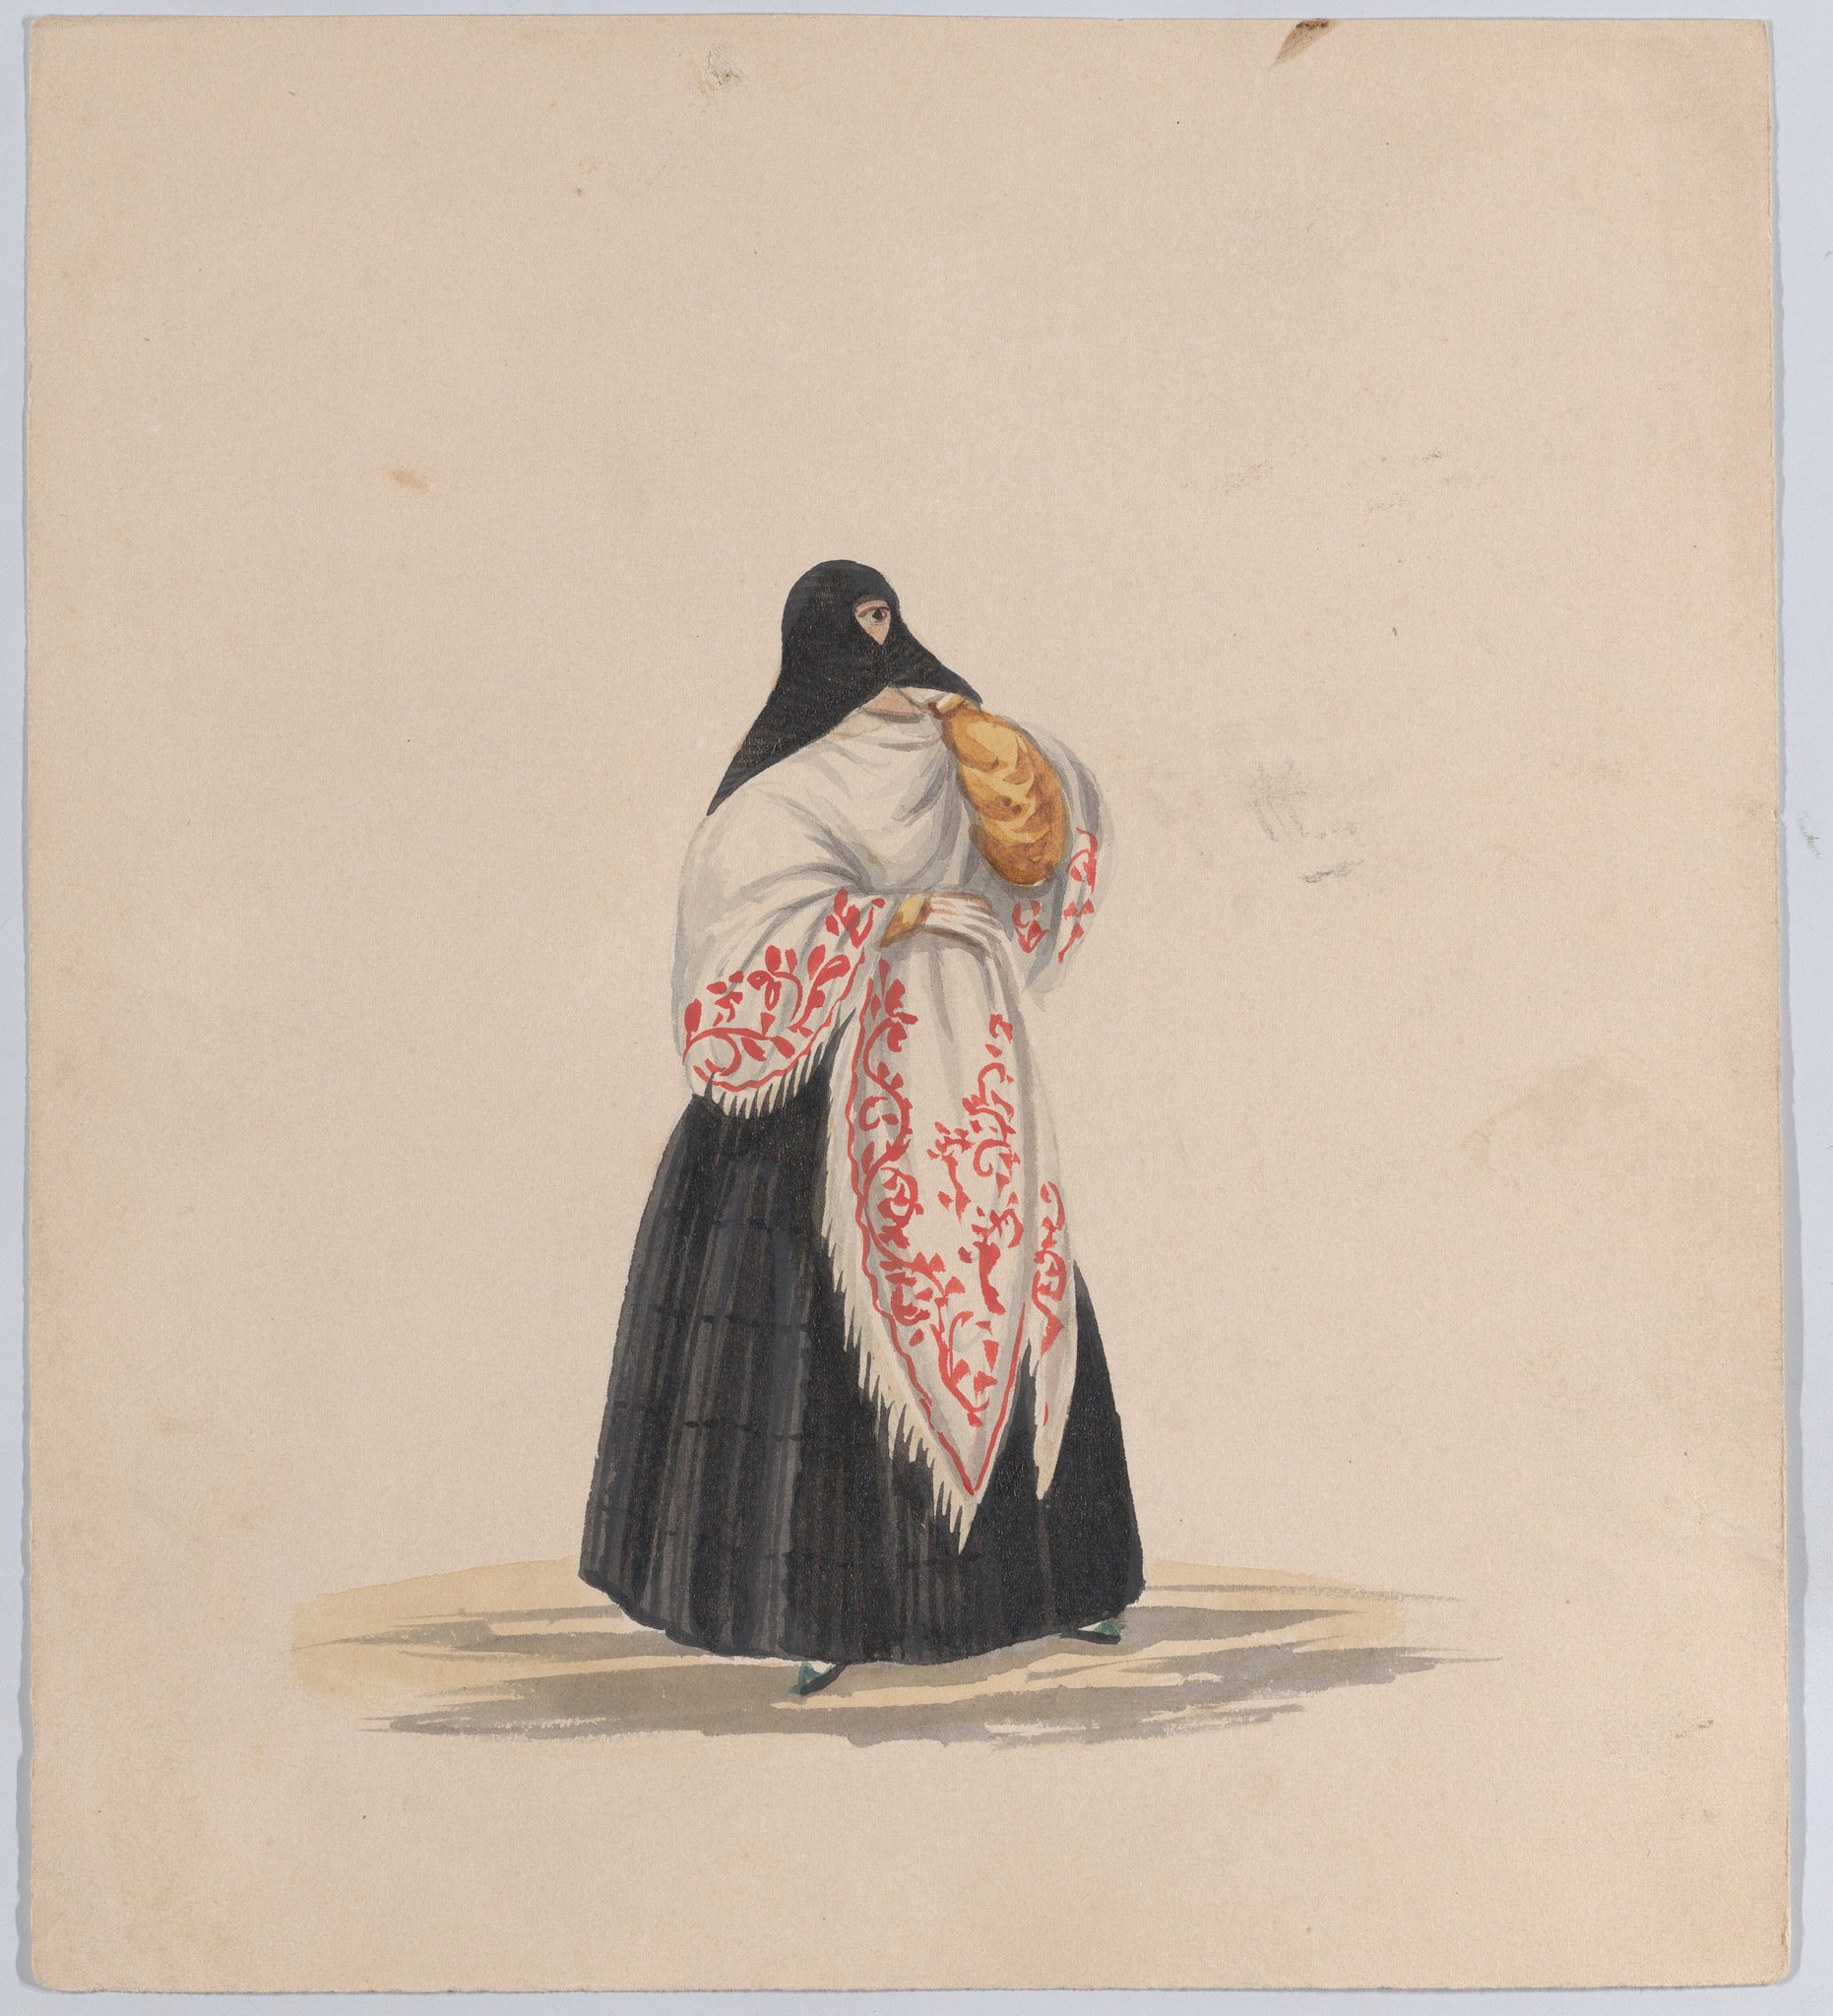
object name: drawing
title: An elegantly dressed woman, from a group of drawings depicting Peruvian dress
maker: francisco (pancho) fierro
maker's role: artist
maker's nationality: african peruvian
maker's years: 1807-1879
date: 1848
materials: watercolor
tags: men,women